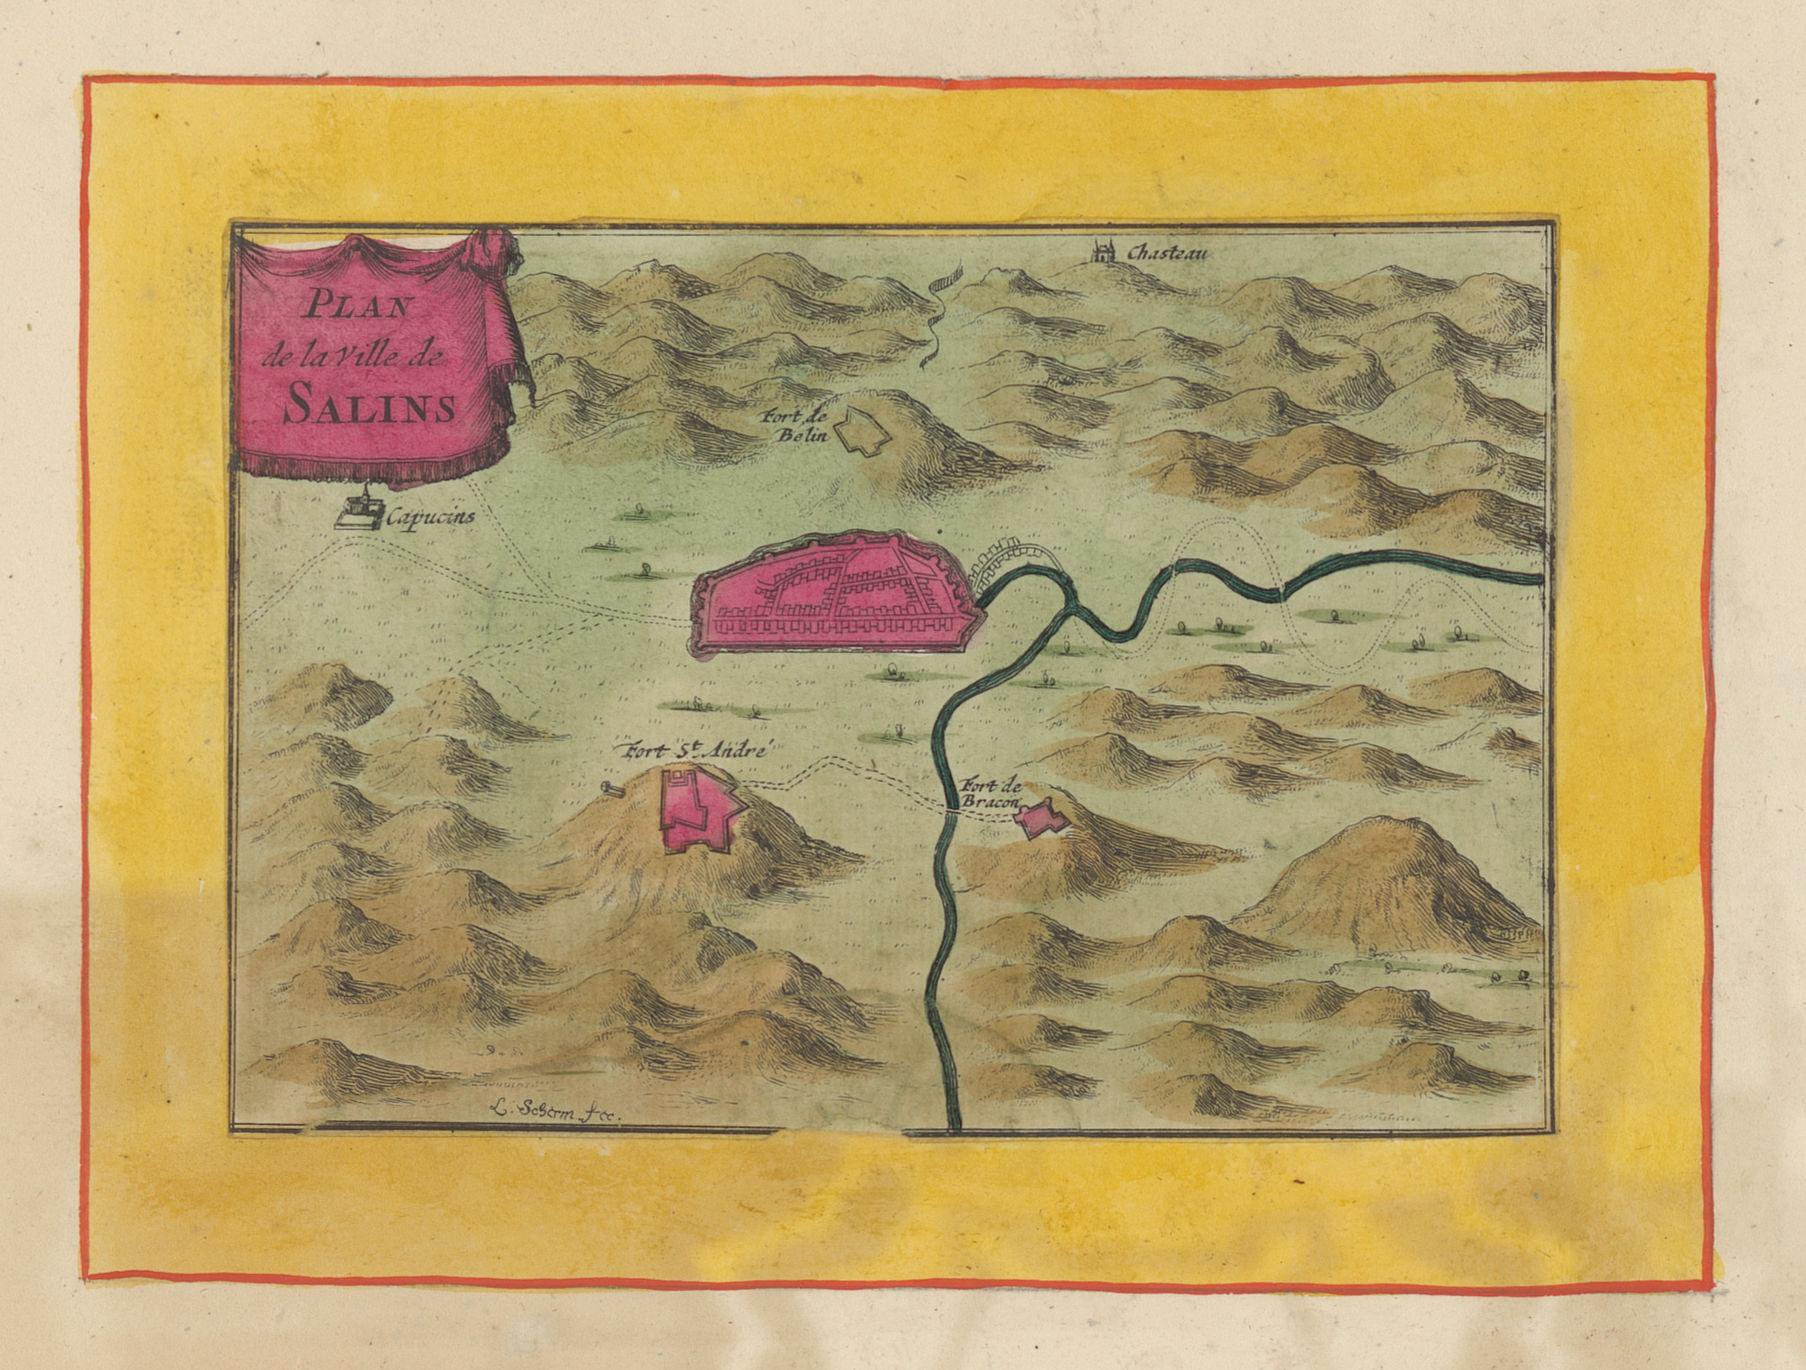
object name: print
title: Plattegrond van Salins-les-Bains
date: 1700-1702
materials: paper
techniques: engraving, hand coloring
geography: the hague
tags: maps of cities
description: Deze plattegrond is in meerdere atlassen gebruikt. Onder andere in: Les forces de l'Europe. 10 dln. Amsterdam: Pieter Mortier, ca. 1700. En in: Les forces de l'Europe. 12 dln. Amsterdam: Pieter Mortier, 1702. Door het ontbreken van de marges van deze prent is onduidelijk om welke staat het gaat. Derhalve is niet te bepalen uit welke van deze publicaties dit exemplaar komt. Later is deze zelfde prent door Pieter van der Aa gebruikt in twee publicaties. Gezien het eind van de werkzame periode van de inkleurder van de prenten in dit album is het niet mogelijk dat deze prent uit een van die publicaties komt.